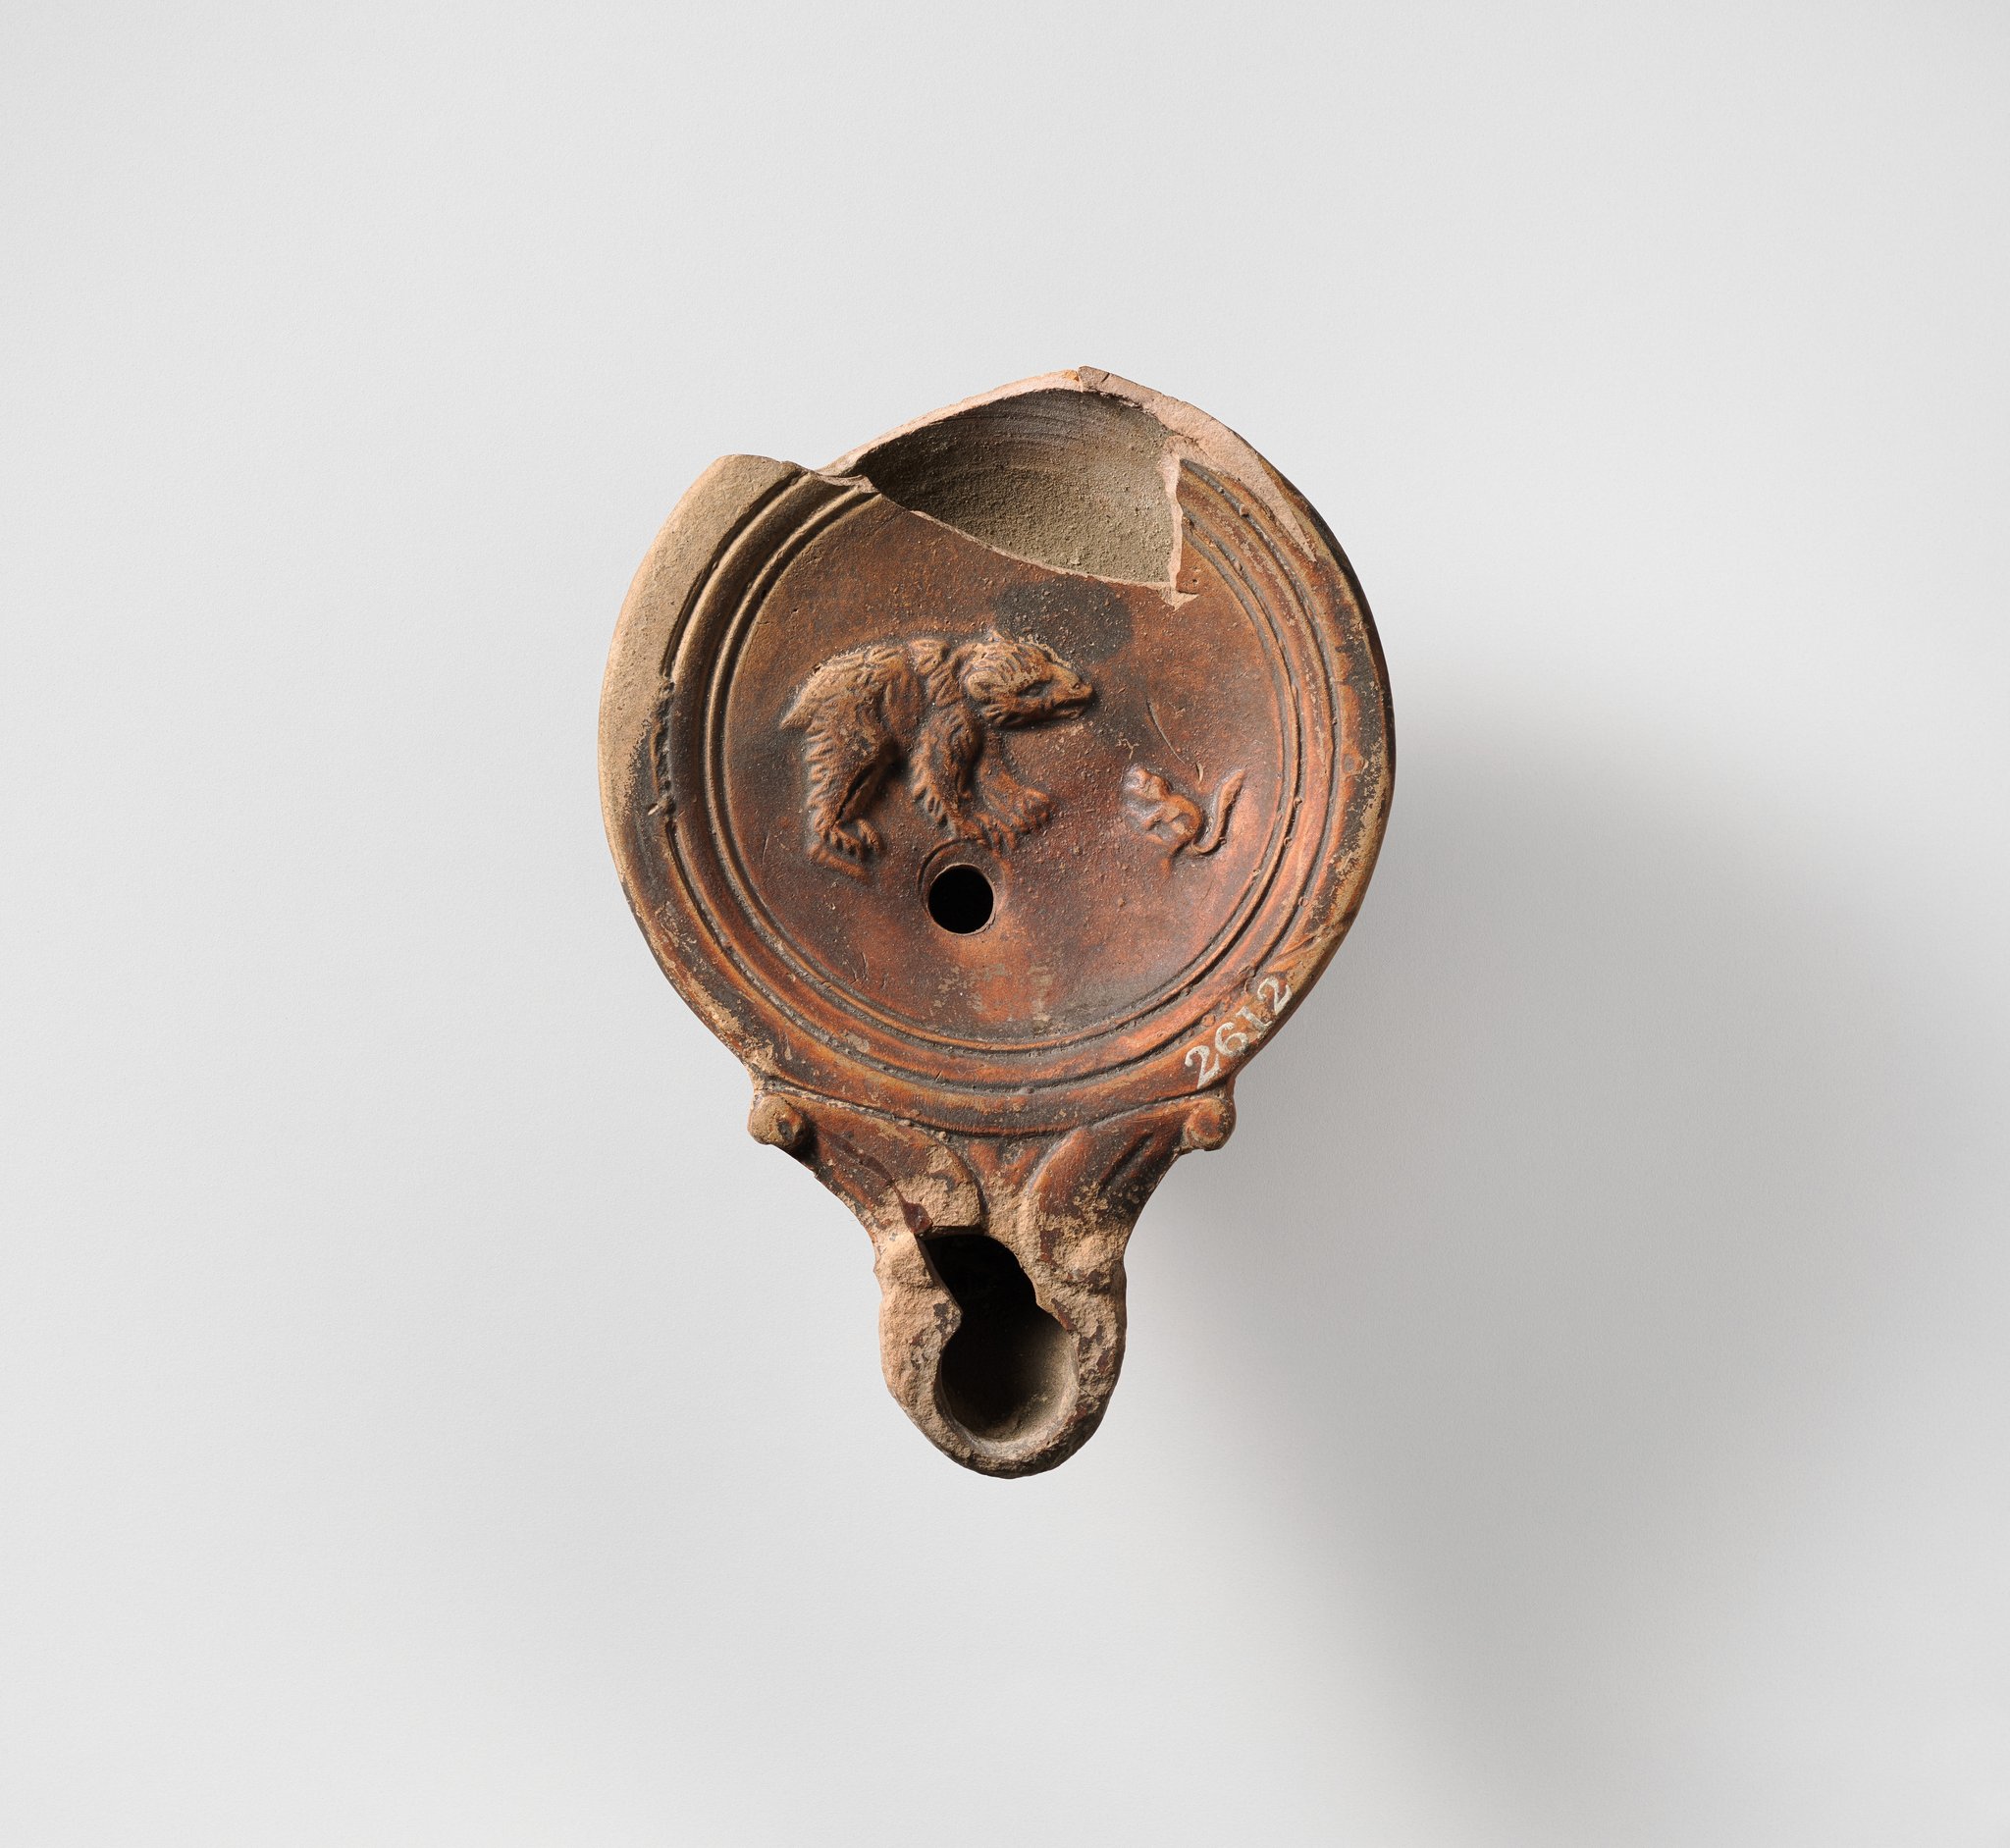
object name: lamp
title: Terracotta oil lamp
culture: roman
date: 100 BCE-100 CE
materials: terracotta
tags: animals,bears